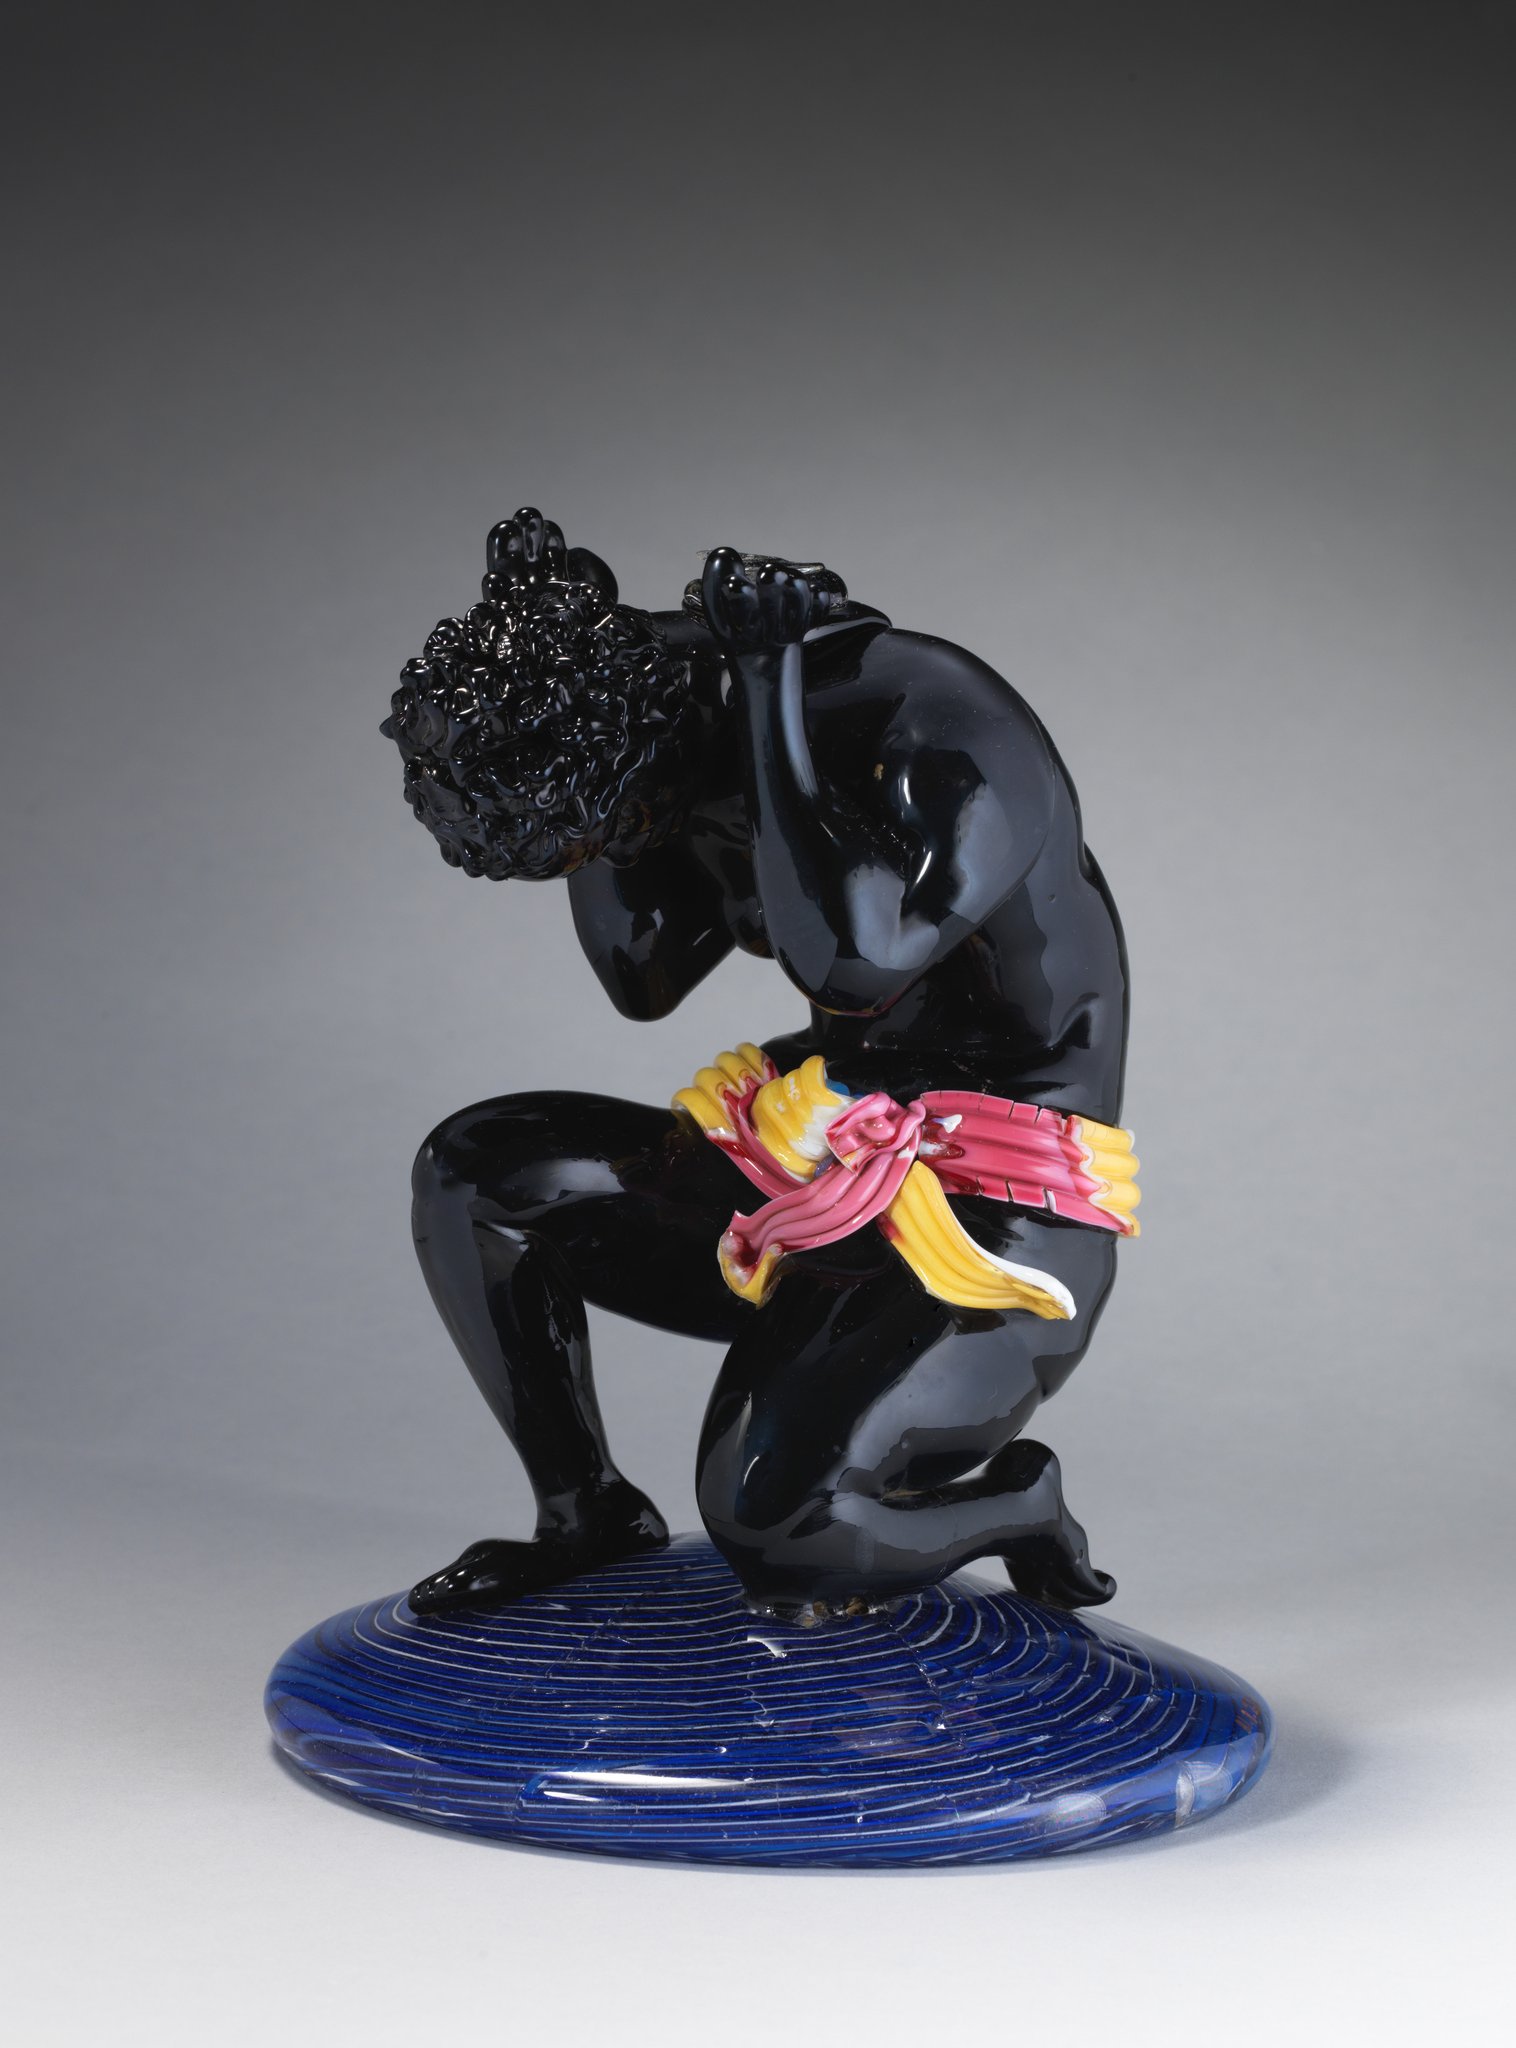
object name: statuette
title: Kneeling African figure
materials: glass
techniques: glassblowing